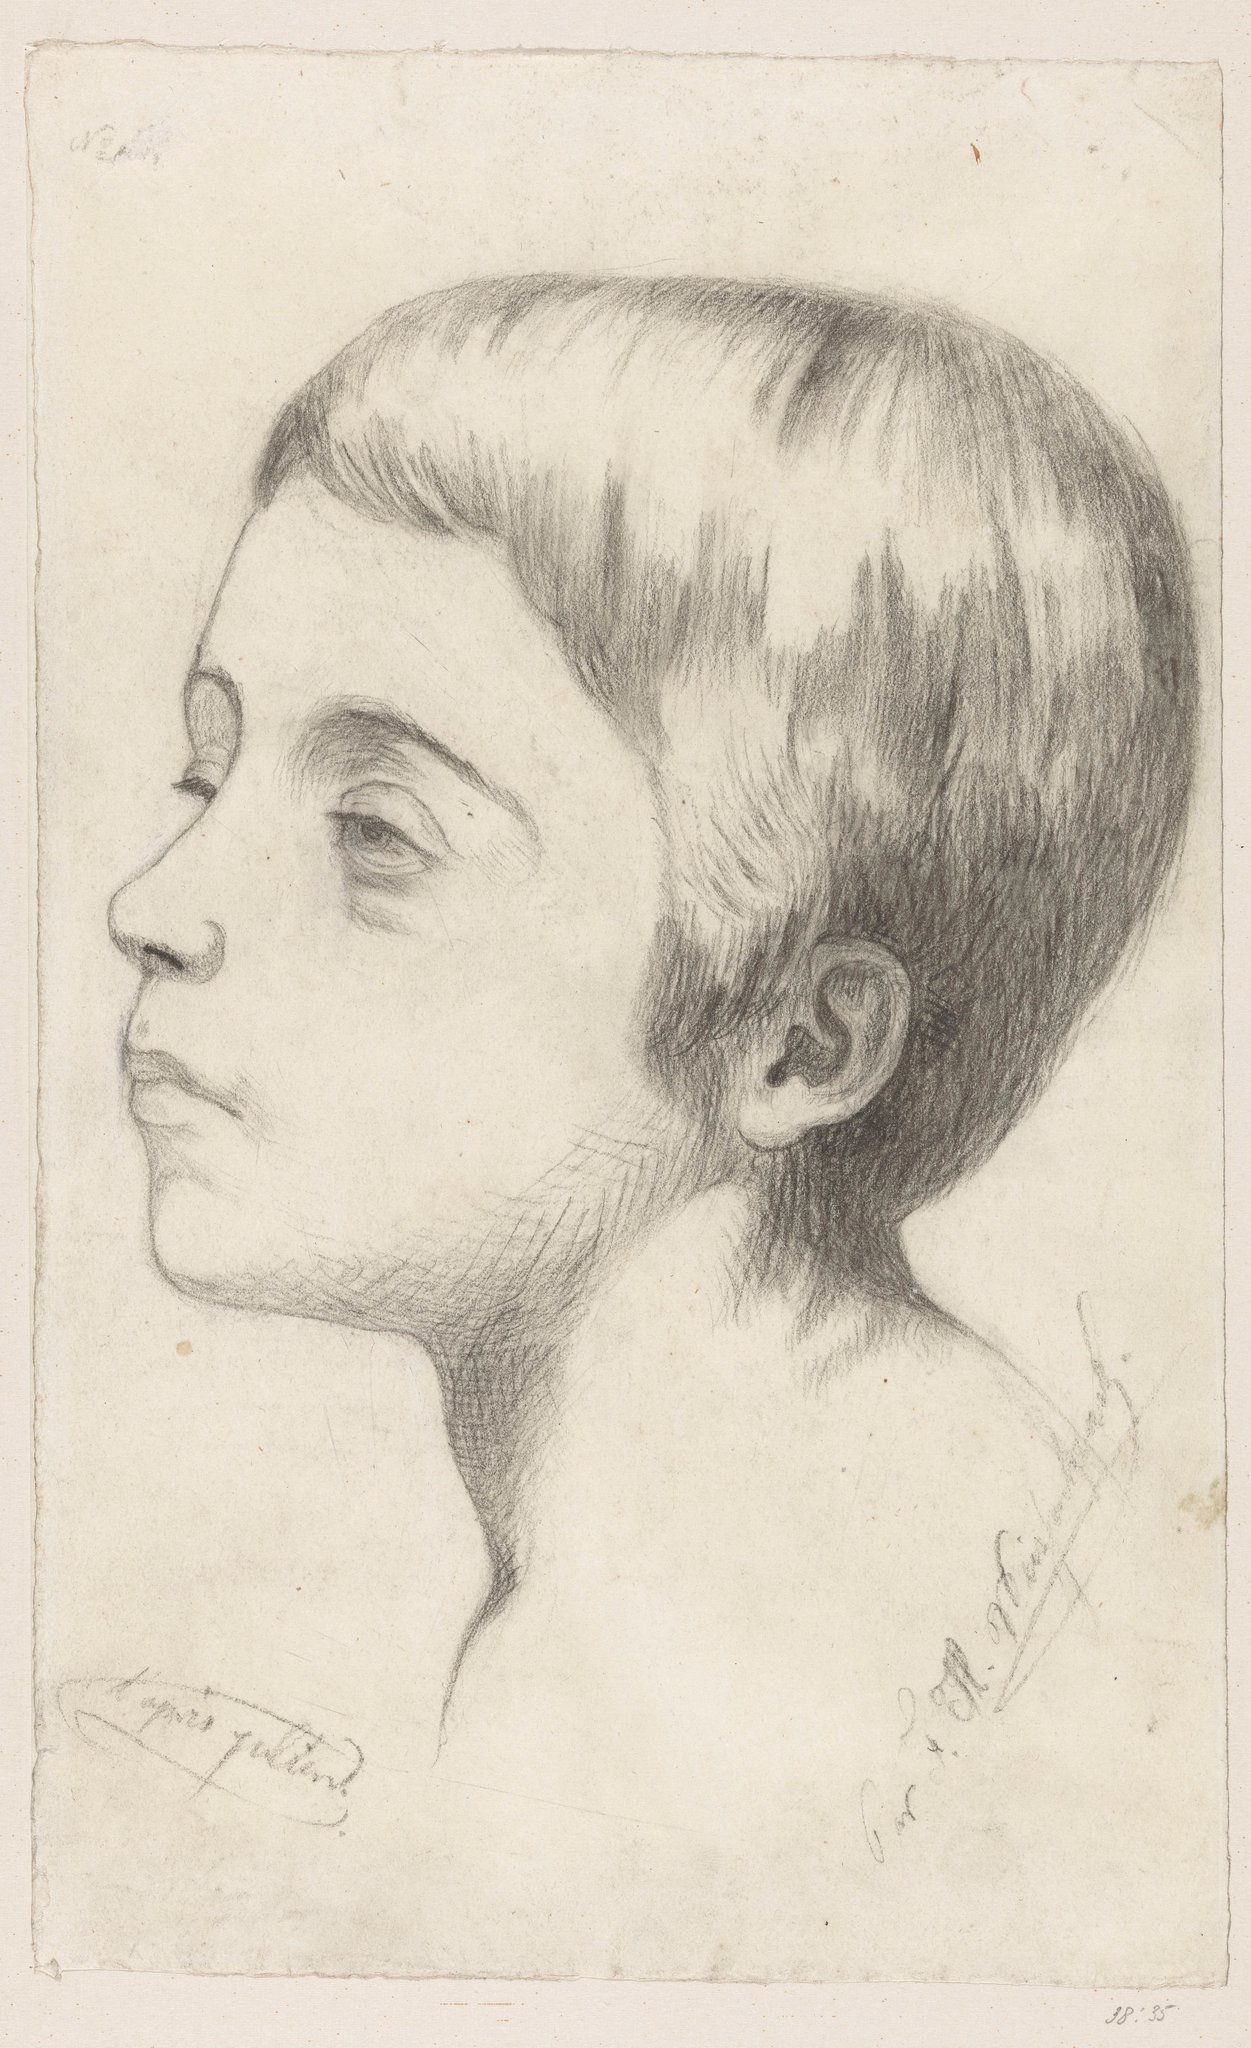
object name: drawing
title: Liggende en staande geit, van achteren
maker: josephus augustus knip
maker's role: draughtsman, painter, print maker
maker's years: 1777-1847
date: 1787-1847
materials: paper, pencil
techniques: brush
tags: goat